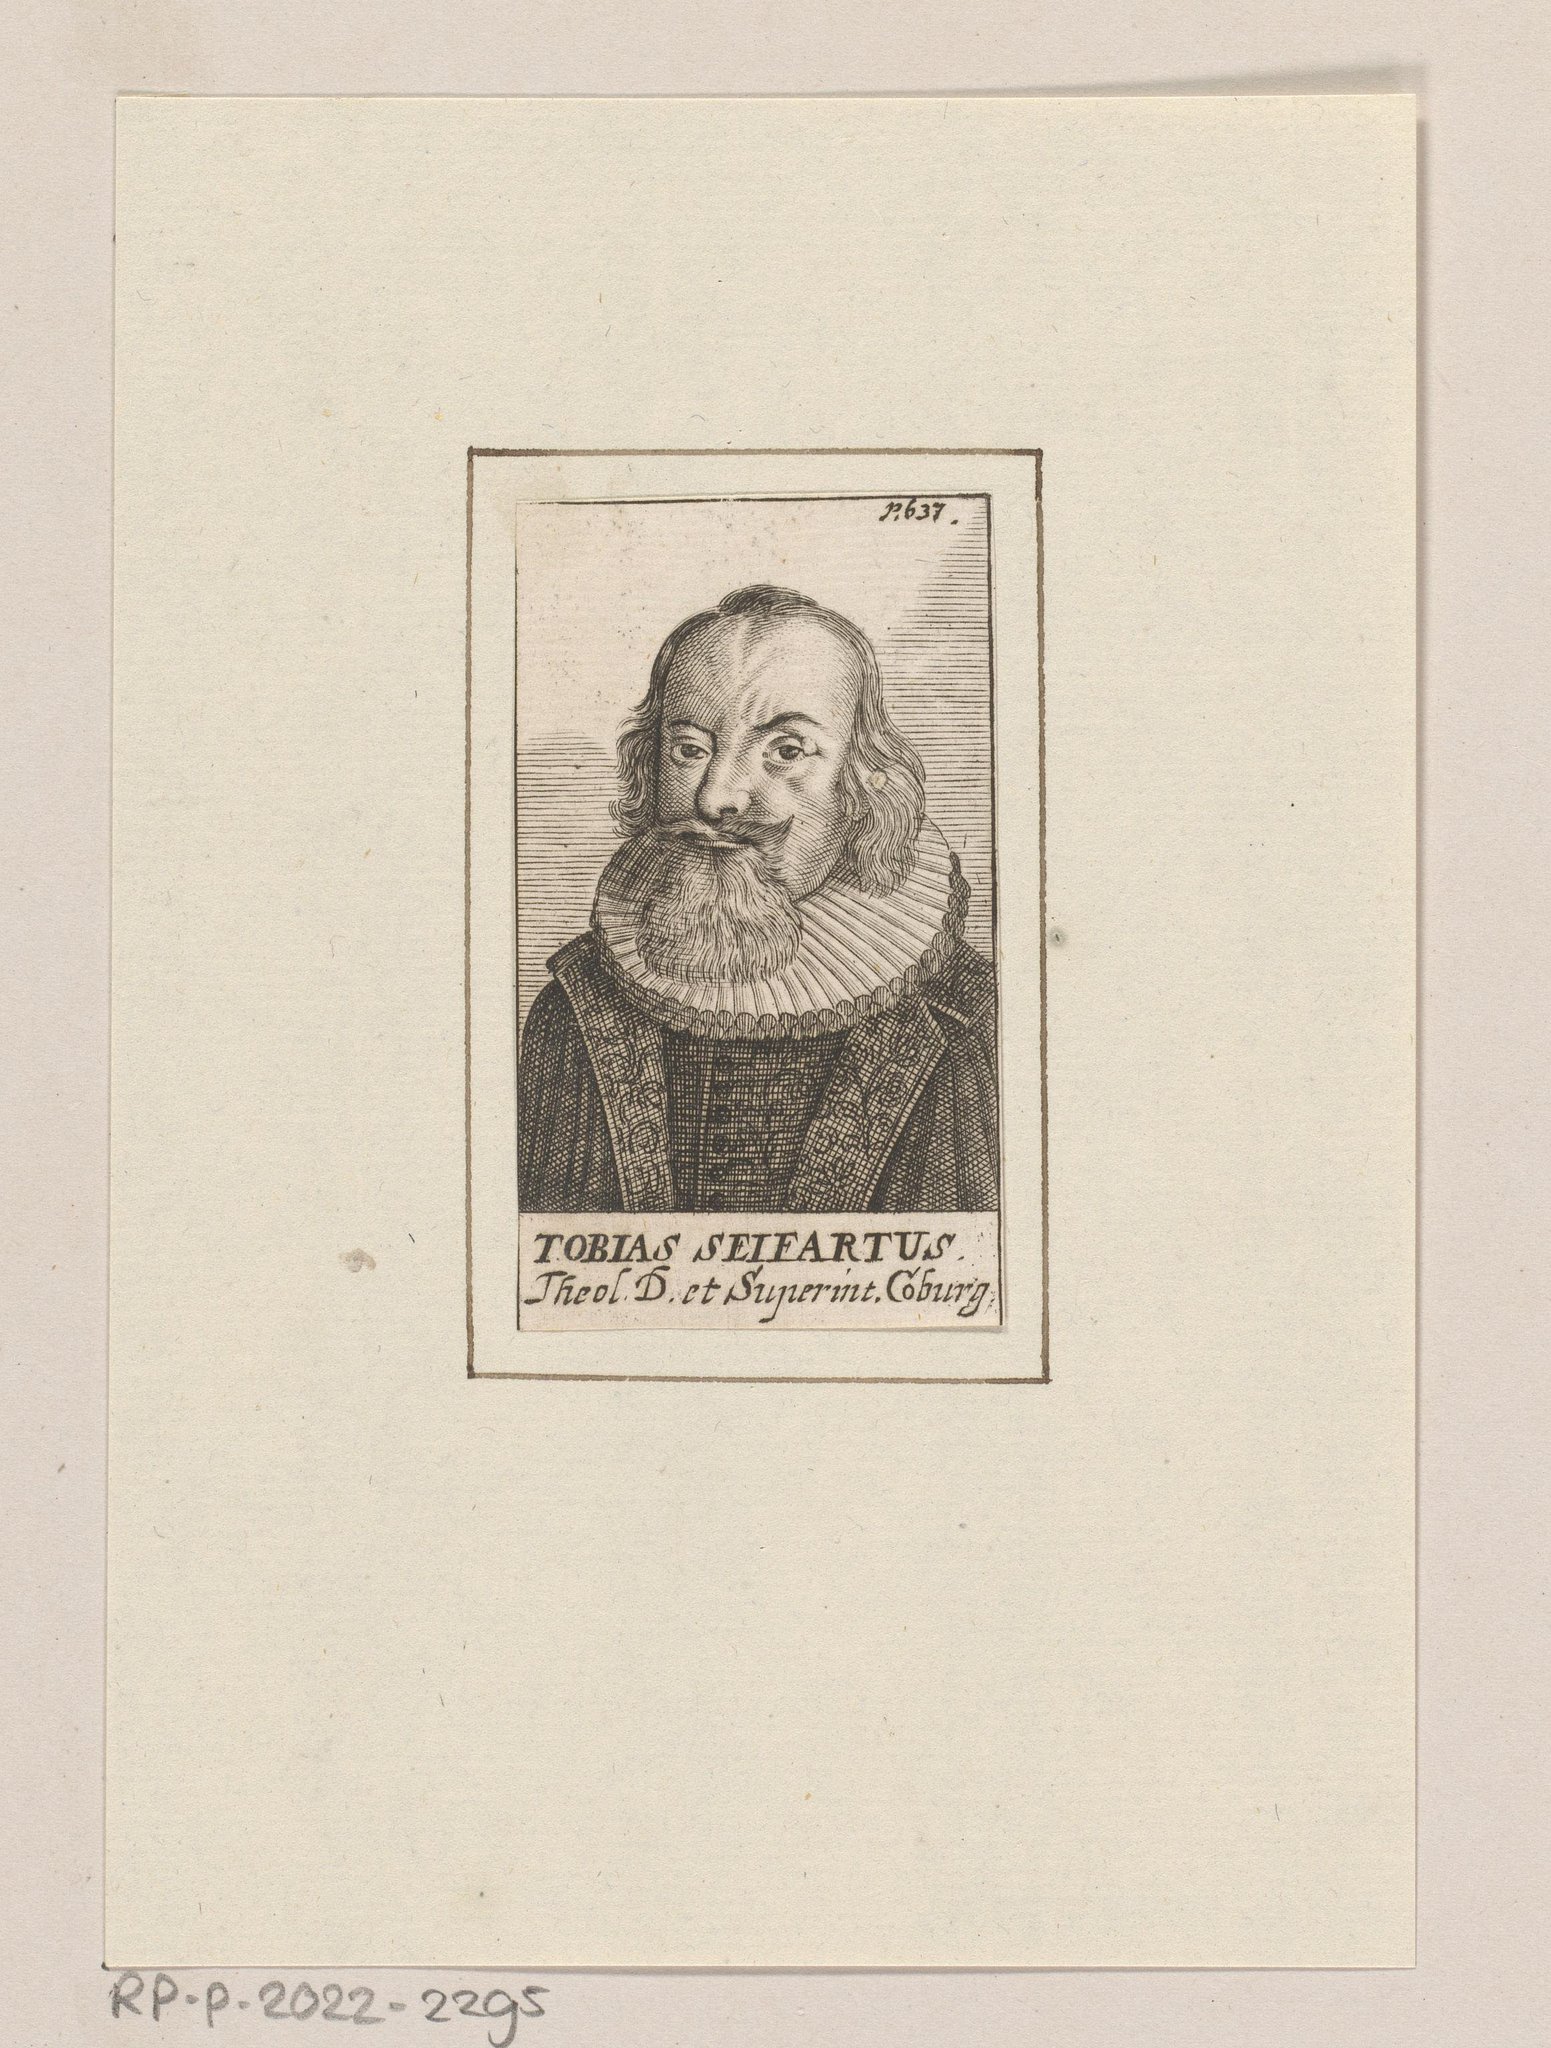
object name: print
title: Portret van Tobias Seifart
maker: Anonymous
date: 1688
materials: ink, paper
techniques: engraving, etching, pen, snipping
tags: theologian, historical persons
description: Prent uit: Freher, Paul. Theatrum virorum eruditione clarorum. Neurenberg: Johann Hoffmann, 1688.